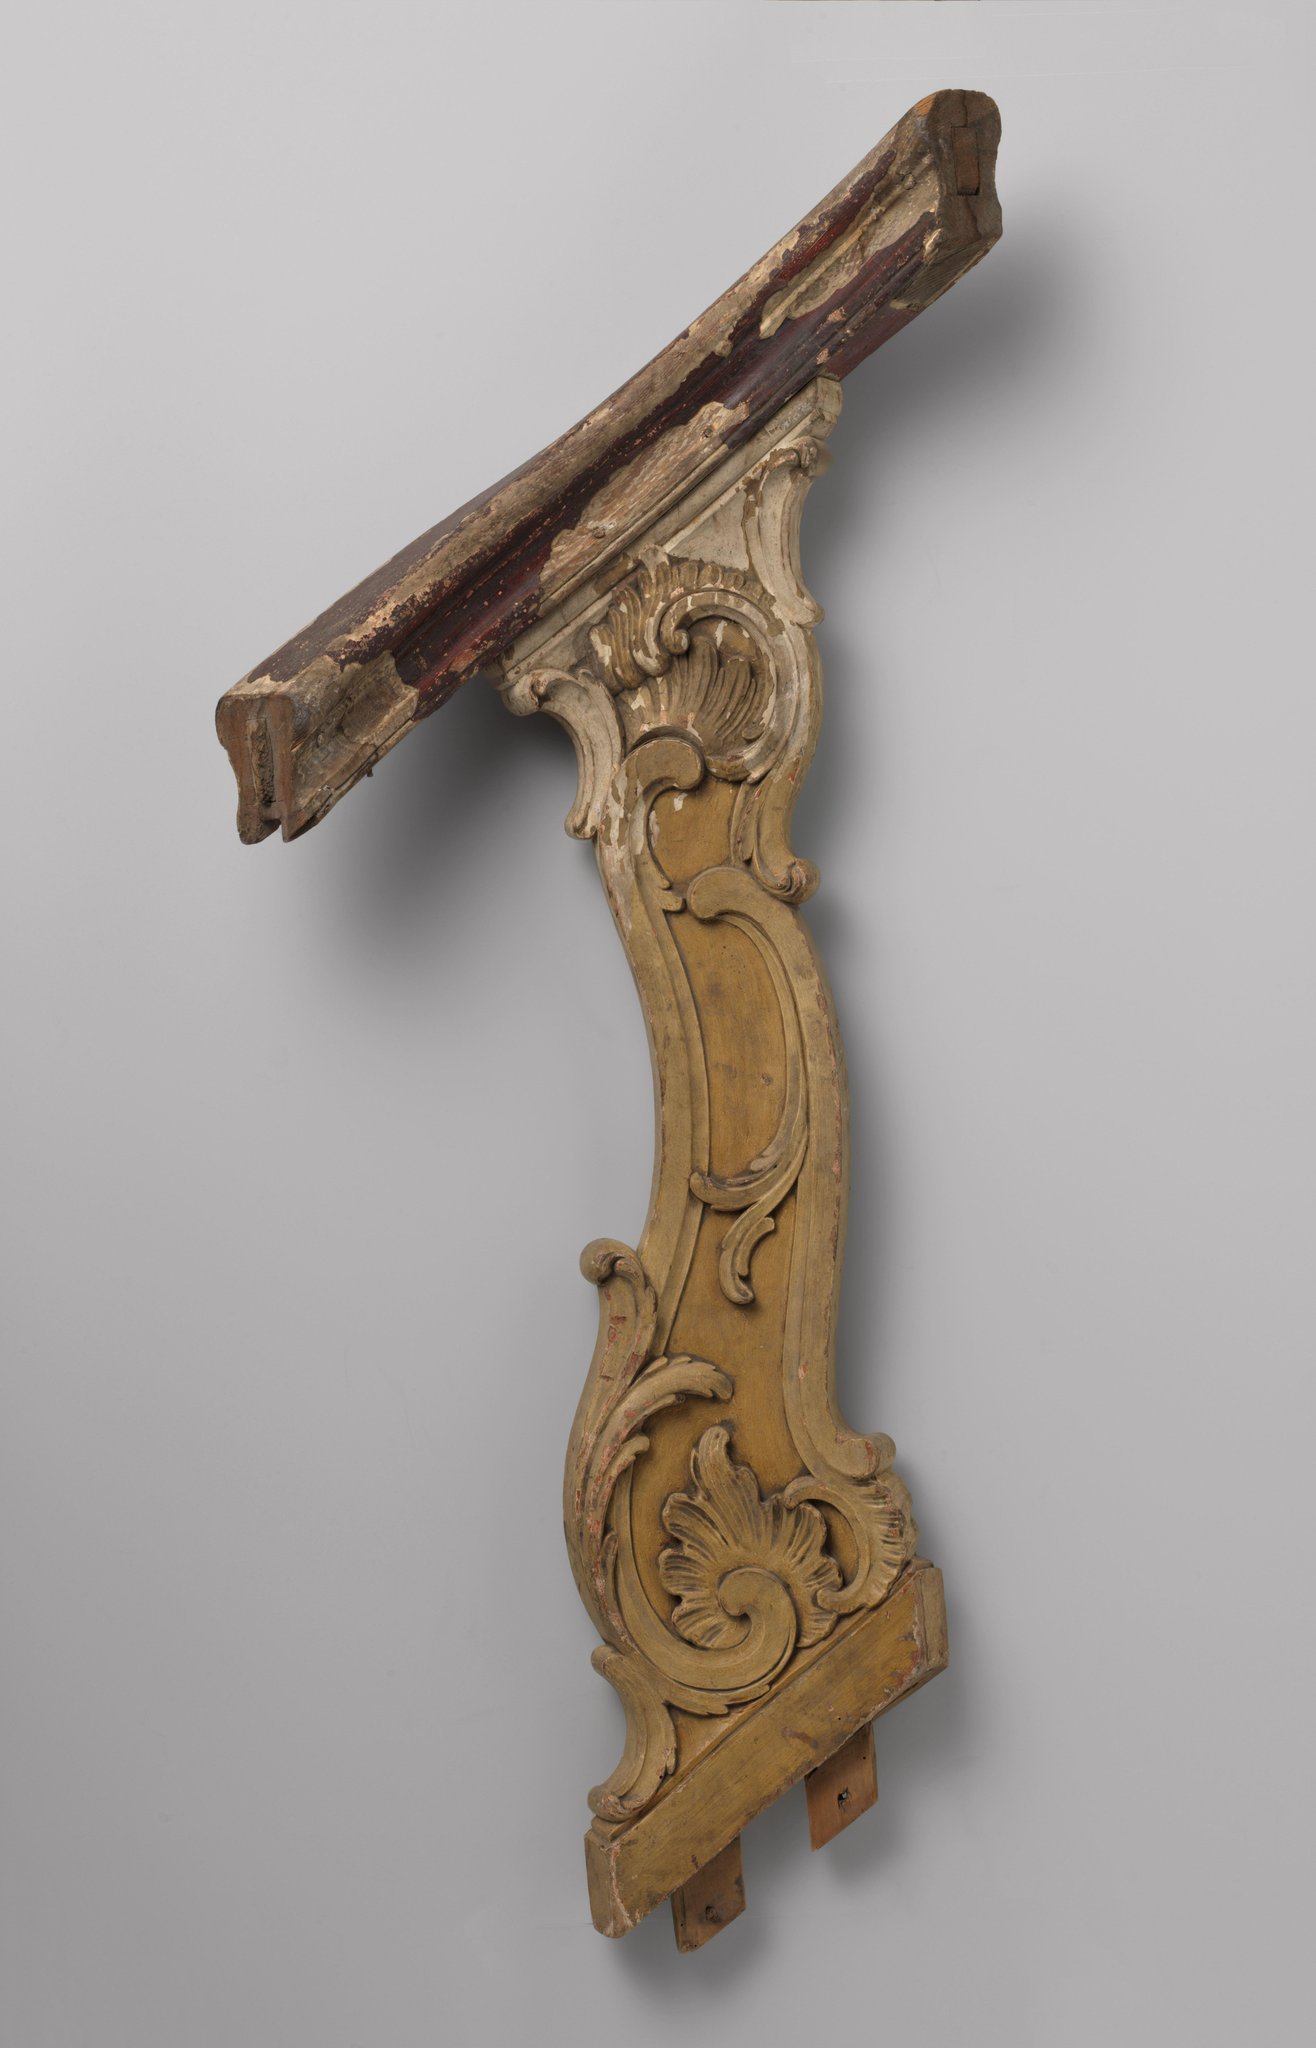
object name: architectural element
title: Baluster met gestoken C- en S-voluten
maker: Anonymous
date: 1740-1760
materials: wood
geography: northern netherlands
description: S-vormige baluster met gestoken C- en S-voluten met rocaille-schelpen.